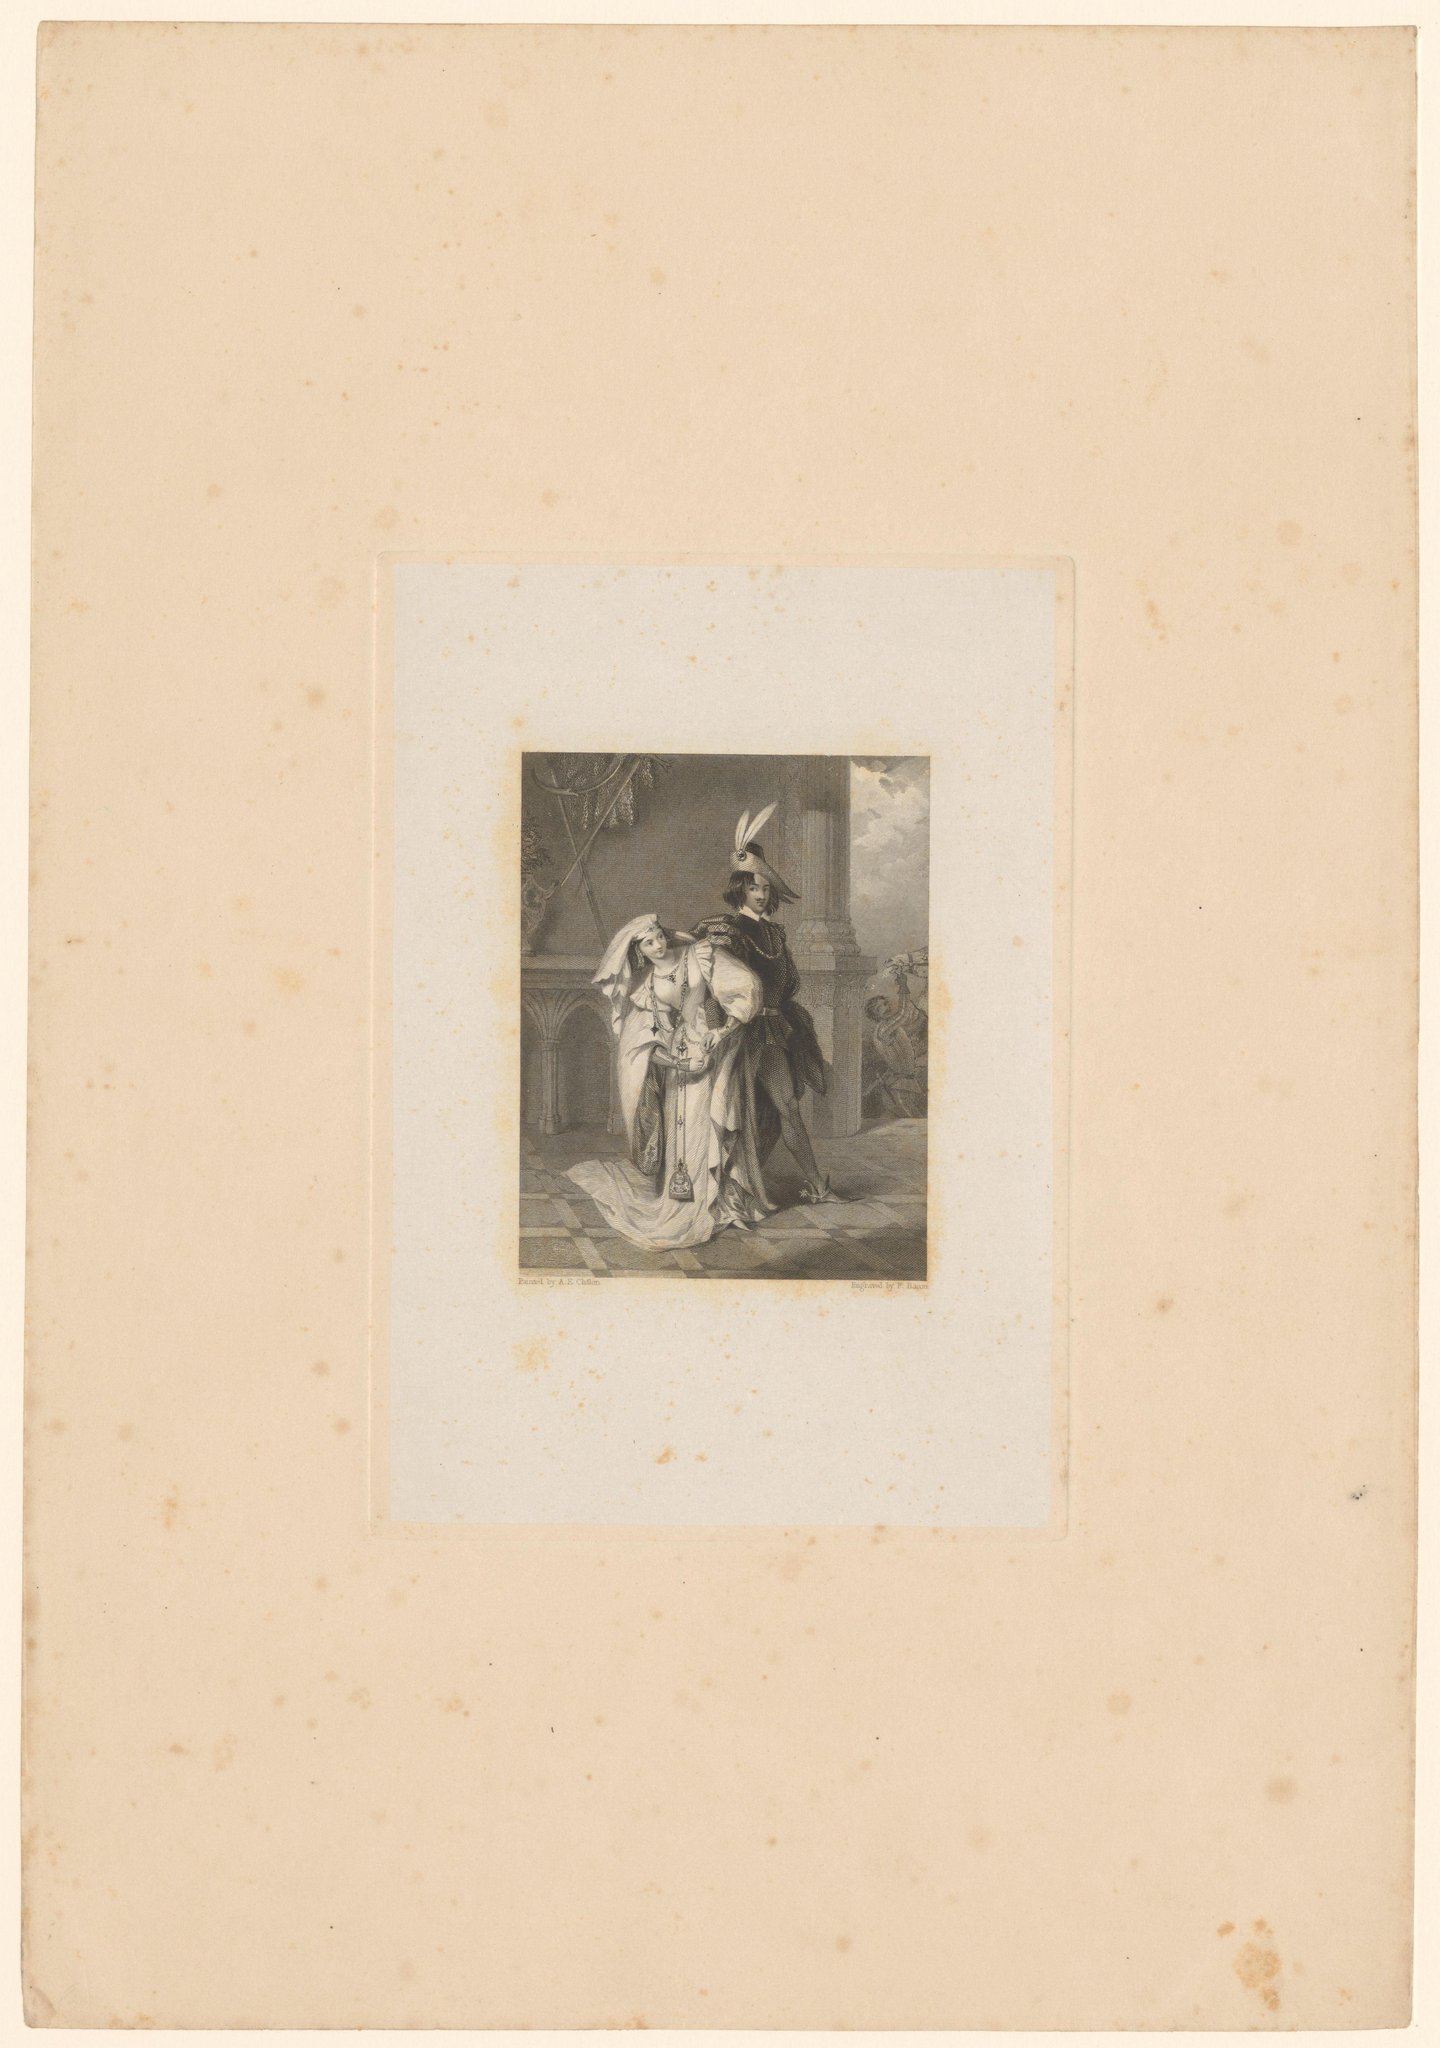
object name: print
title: Vrouw schuift een vertrekkende edelman een ring om de vinger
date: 1831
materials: paper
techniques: engraving, etching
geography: england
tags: courtly love, nobility and patriciate; chivalry, knighthood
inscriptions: collector's mark: Lugt 2228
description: Prent uit: Heath's Picturesque Annual, 1831. Prent ook gebruikt voor: The Keepsake, 1832, tussen p. 90 en 91.